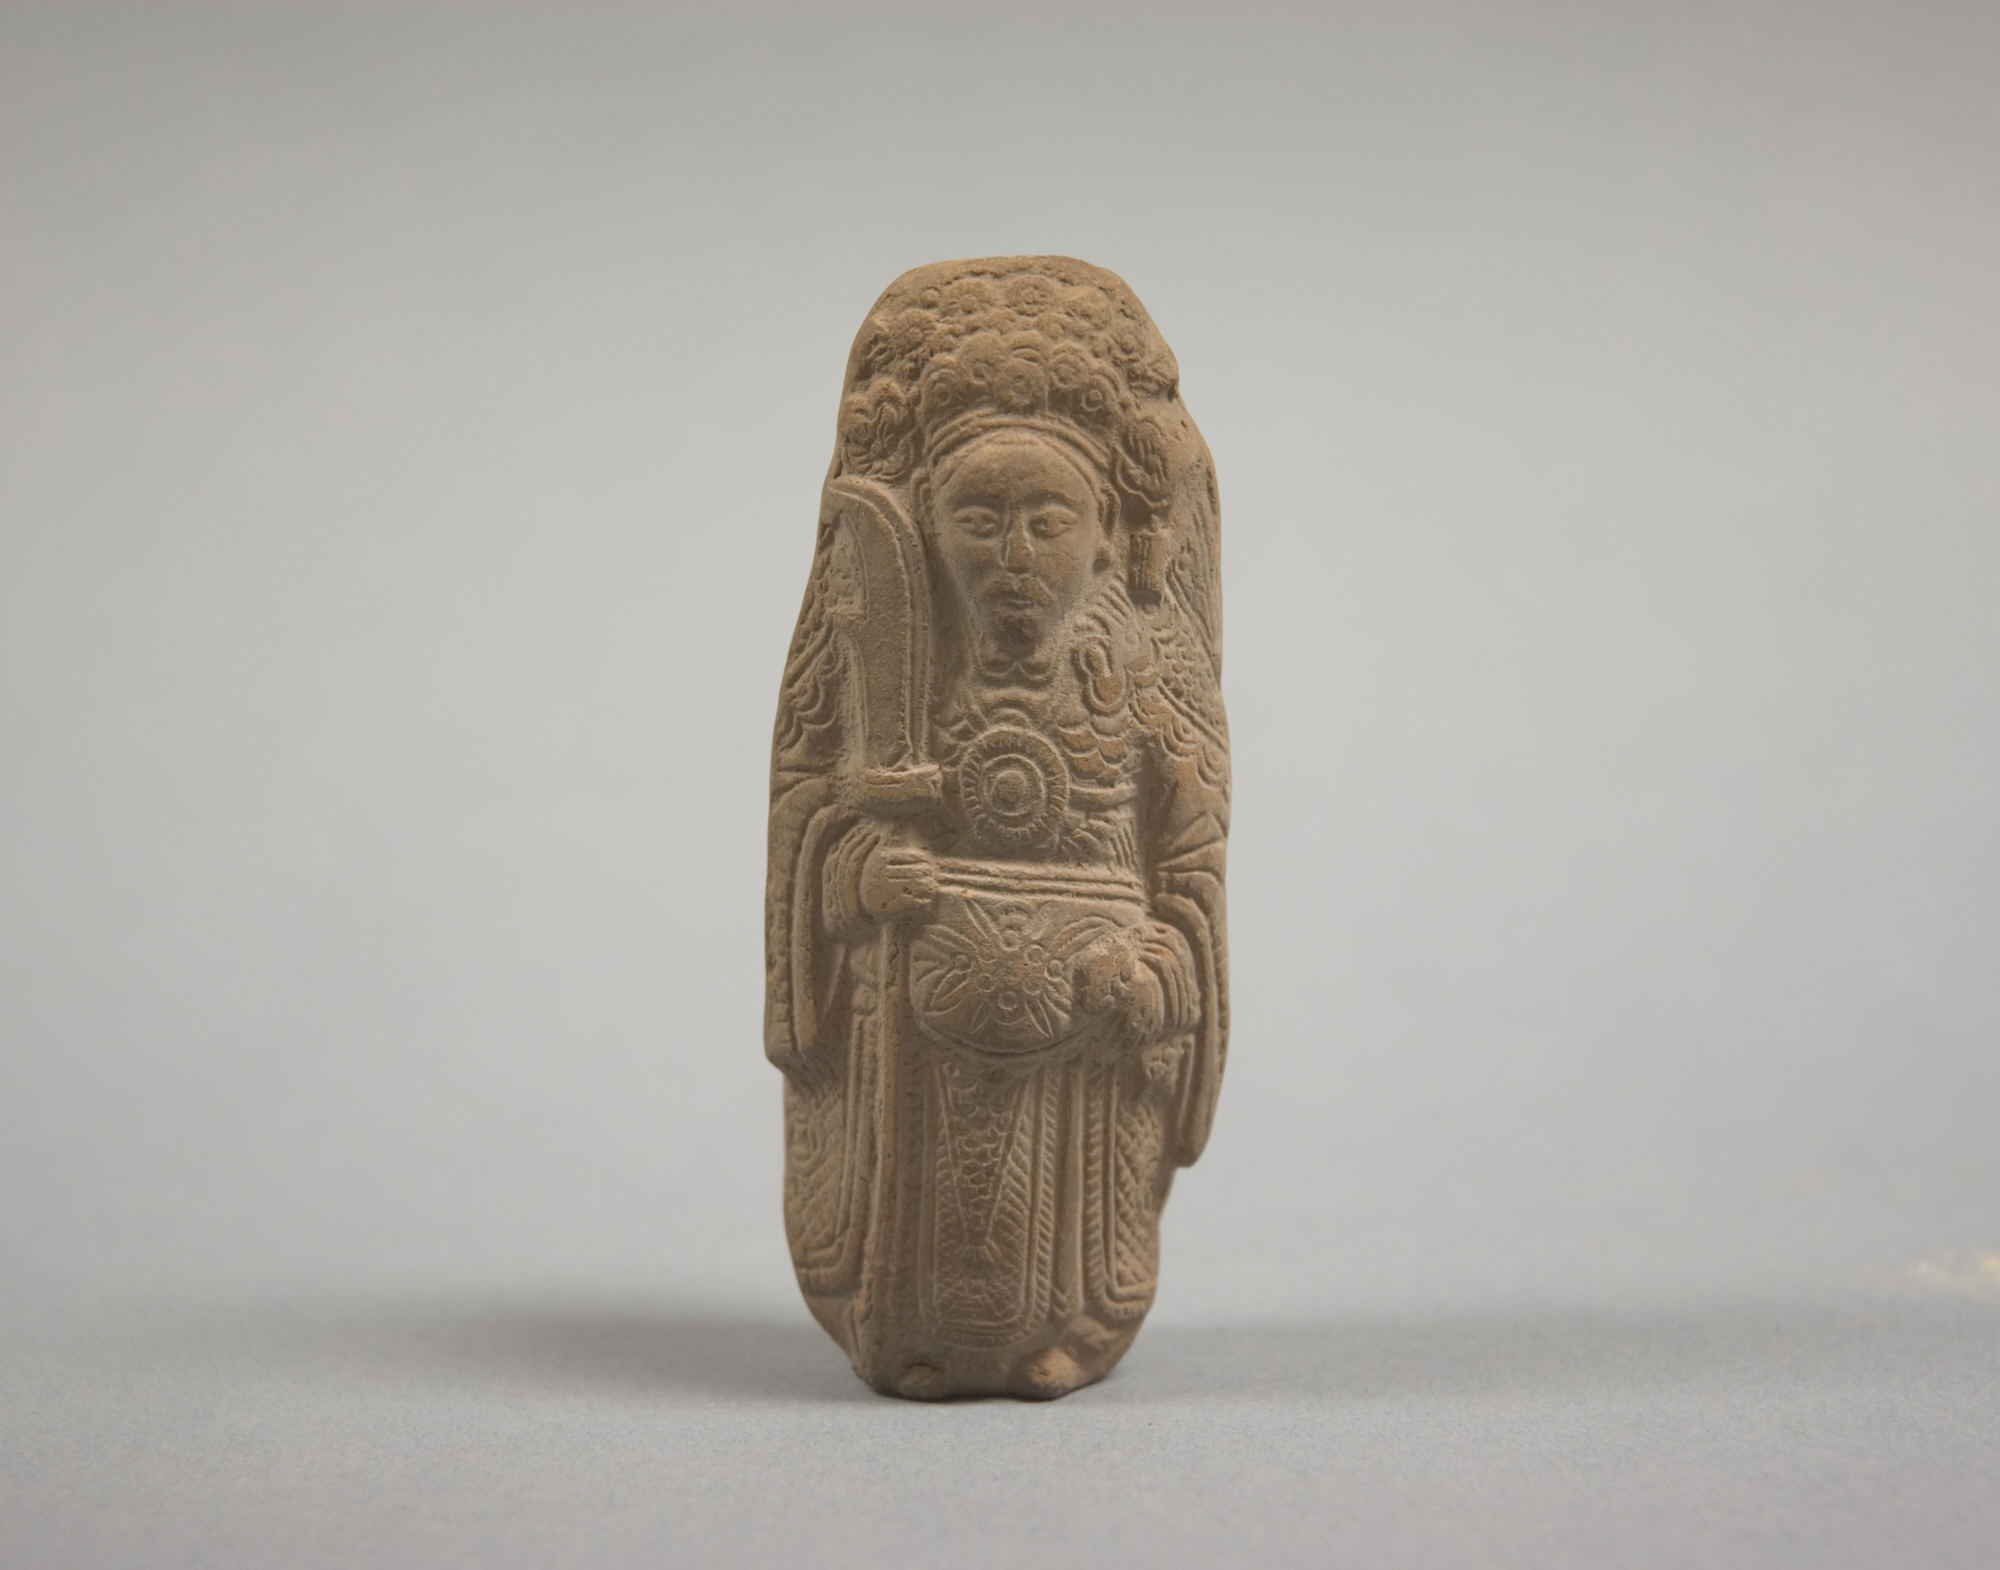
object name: figure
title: Figure of Warrior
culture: chinese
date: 960-1279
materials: pottery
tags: men